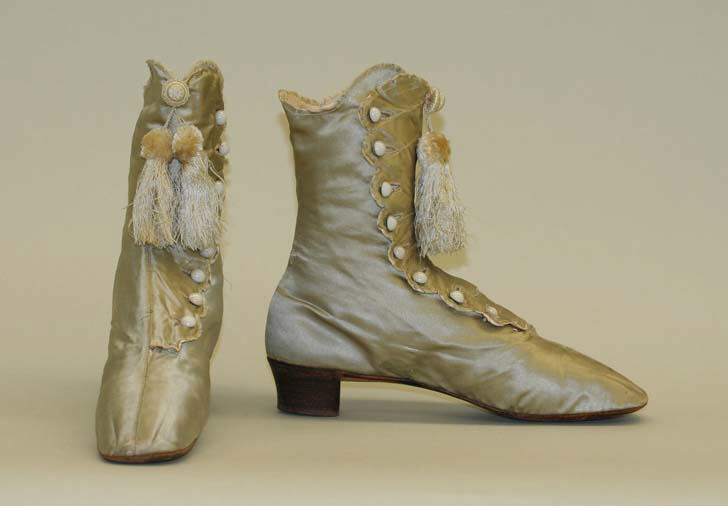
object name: wedding shoe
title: Wedding shoes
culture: american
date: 1865